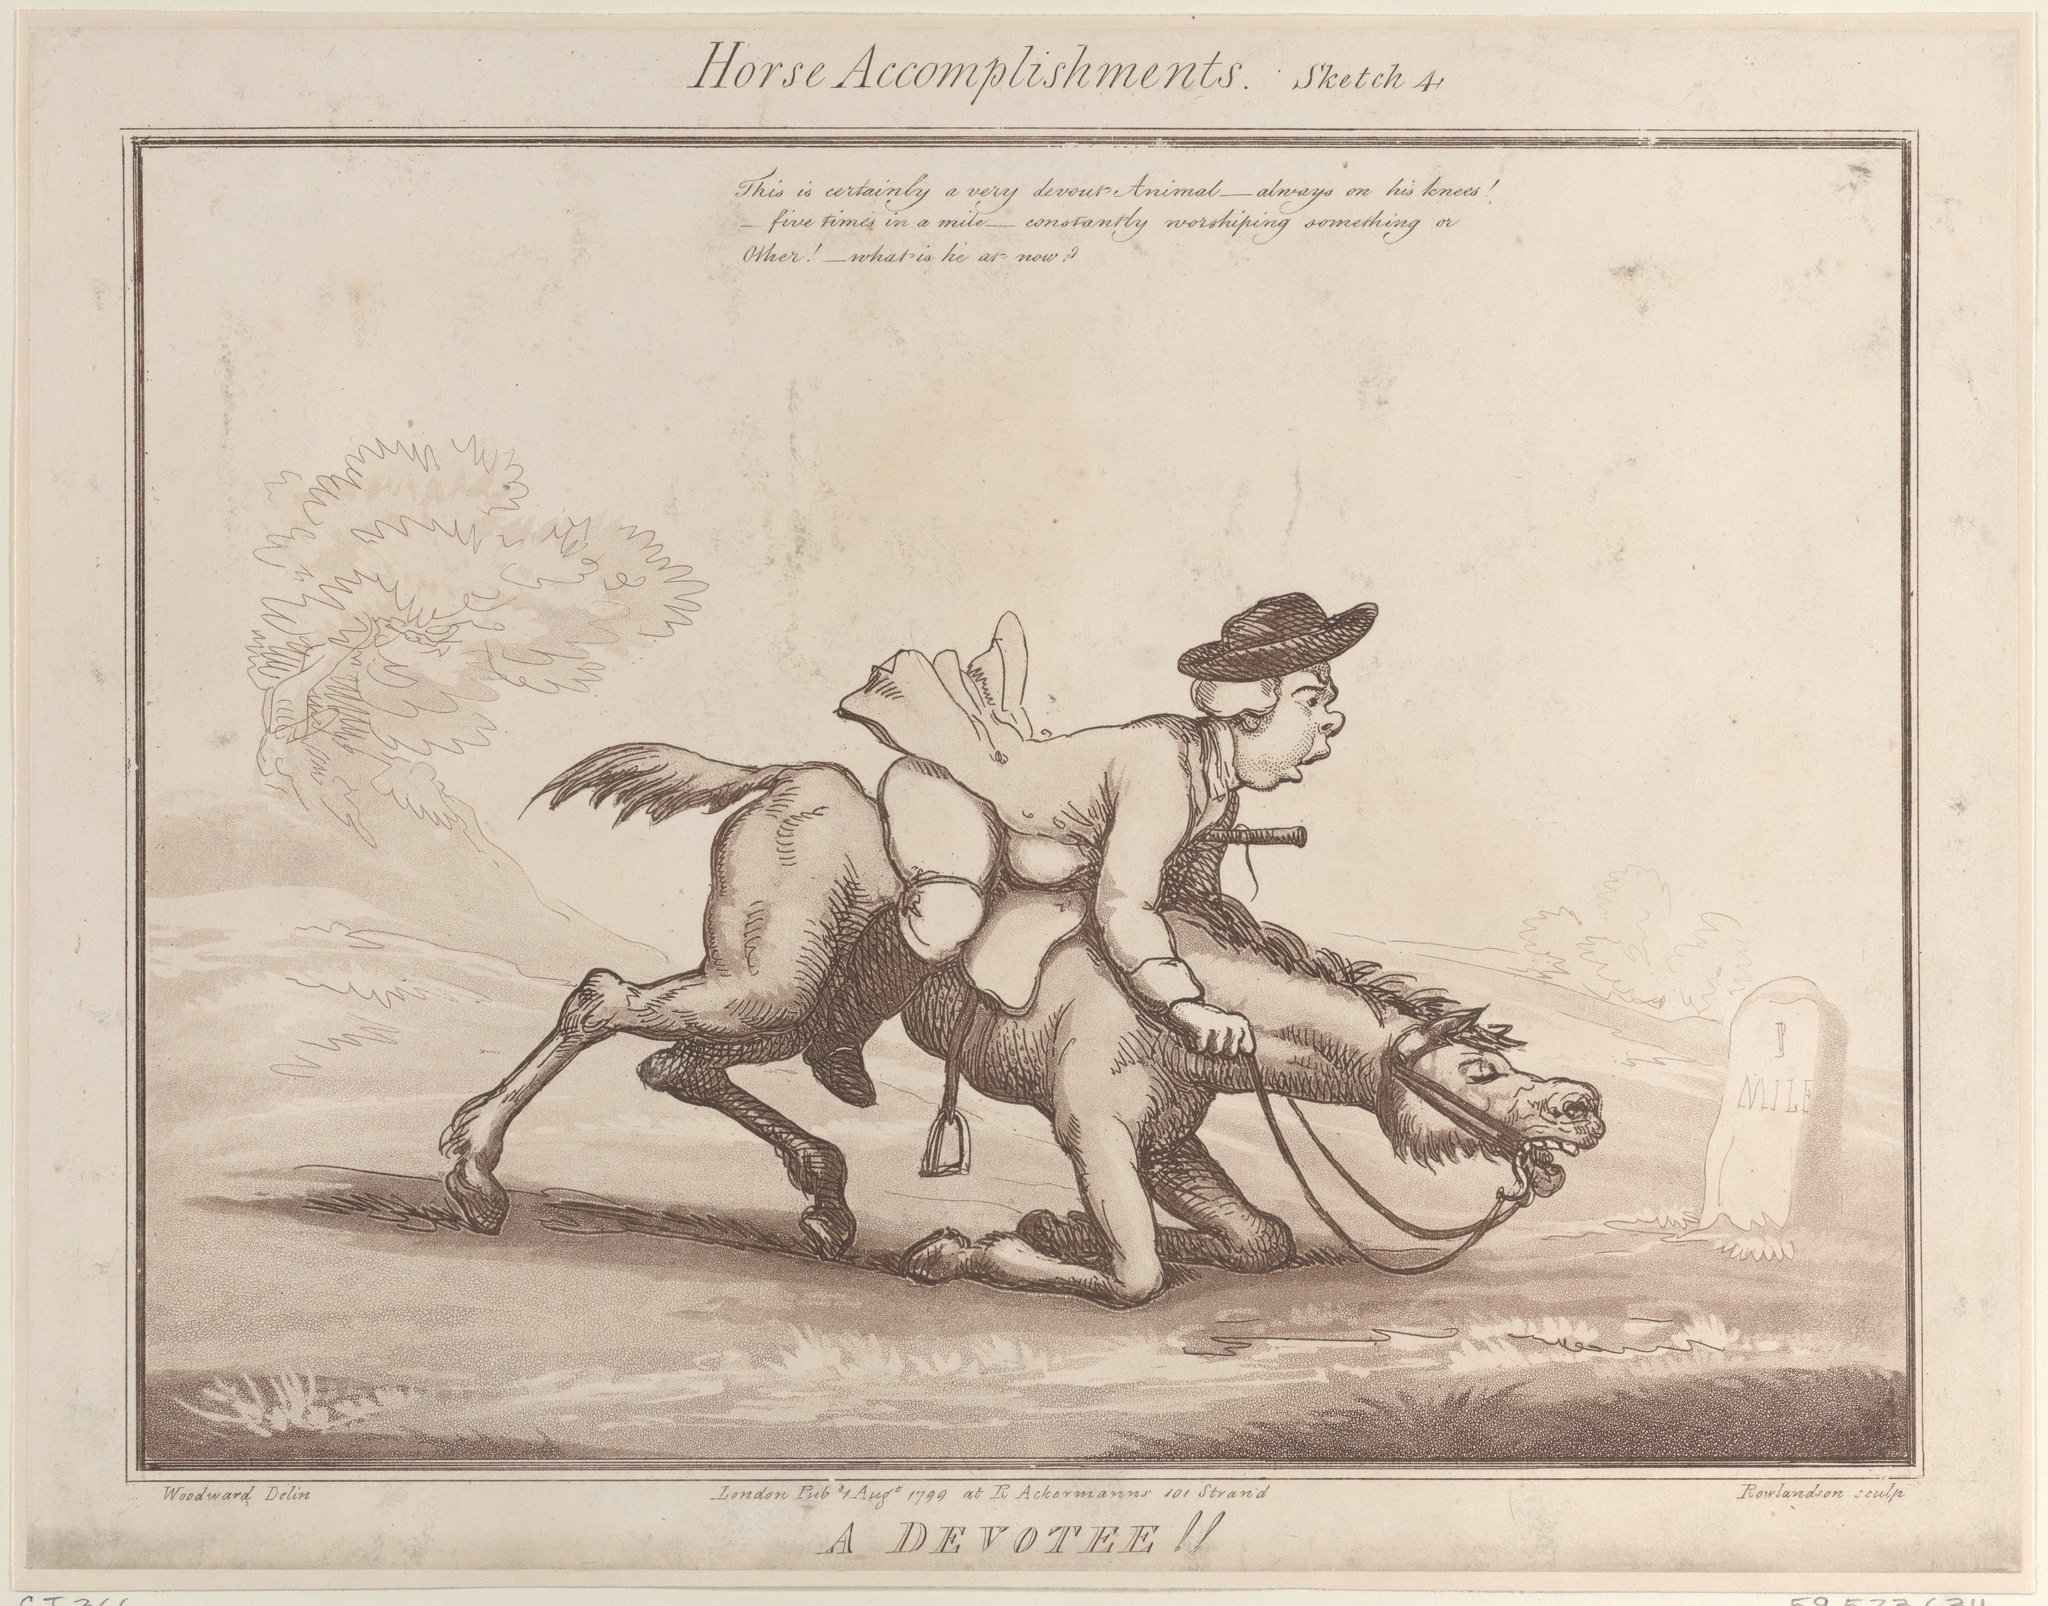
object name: print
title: Horse Accomplishments, Sketch 4: A Devotee !!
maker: thomas rowlandson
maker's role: artist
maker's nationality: british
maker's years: 1757-1827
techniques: aquatint, etching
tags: satire,men,horses,caricature